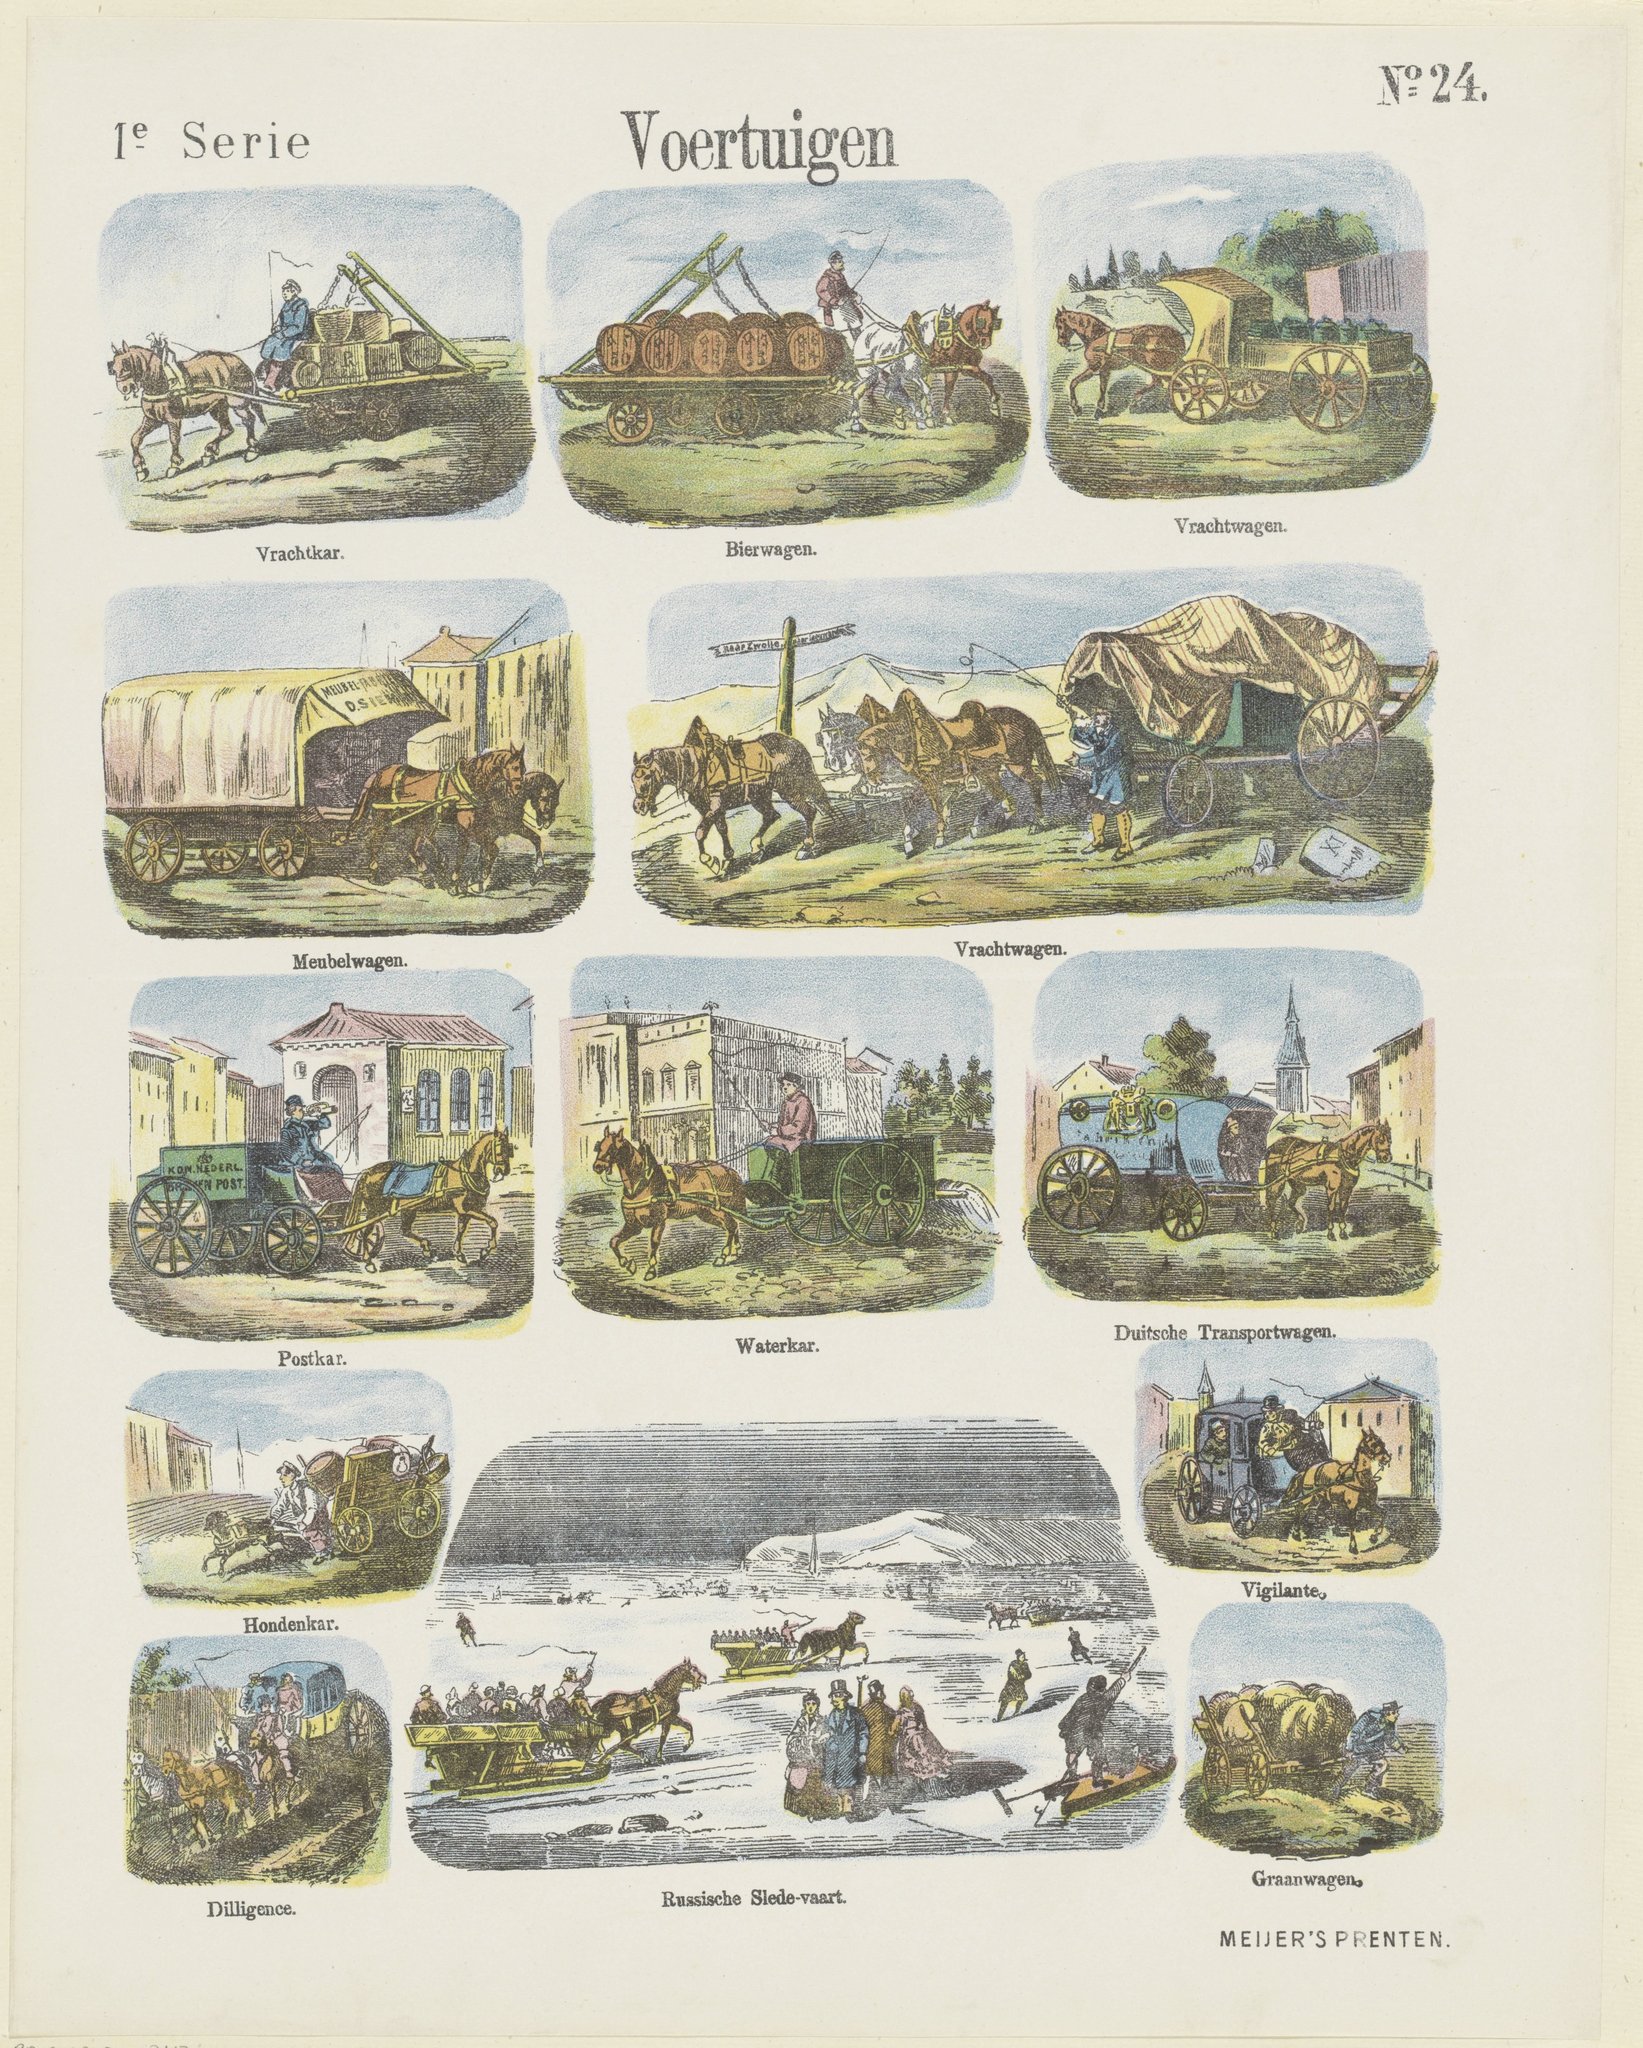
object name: print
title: Meijer's prenten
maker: Anonymous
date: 1873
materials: paper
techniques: lithograph, letterpress printing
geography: amsterdam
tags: diligence, omnibus, horse-tram, traffic and transport, four-wheeled, animal-drawn vehicle, e.g.: cab, carriage, coach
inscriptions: collector's mark: Lugt 2760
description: Blad met 13 voorstellingen van voertuigen, waaronder een bierwagen, een vrachtwagen, een postkar en een diligence of reiskoets. Onder elke afbeelding een onderschrift. Genummerd rechtsboven: No. 24.